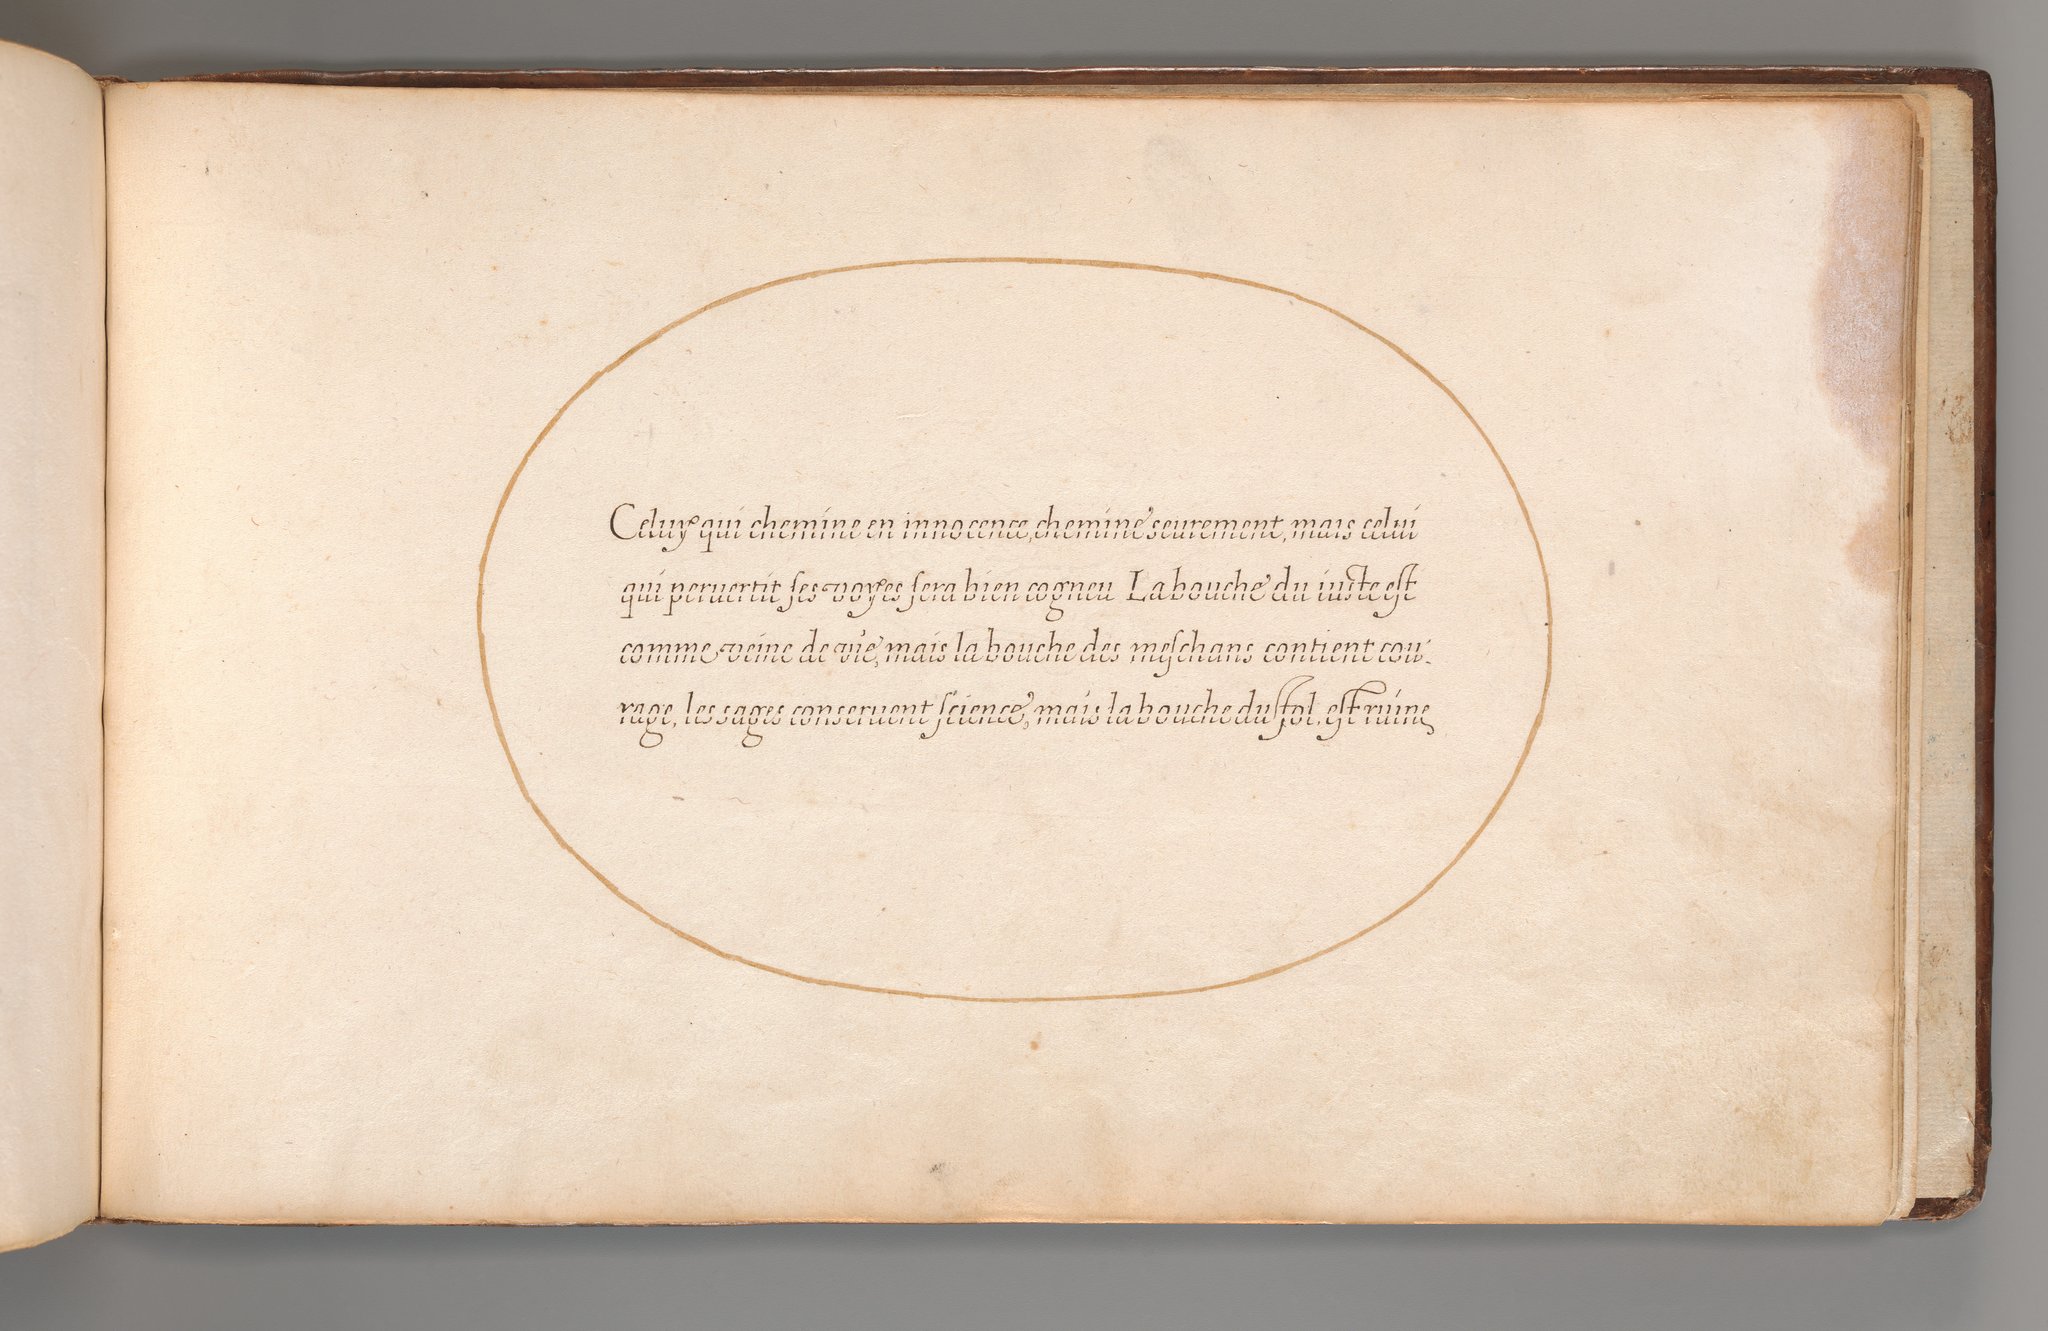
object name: album print ornament architecture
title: Calligraphic Exercise in French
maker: Anonymous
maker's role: artist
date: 1601-1633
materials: ink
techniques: pen